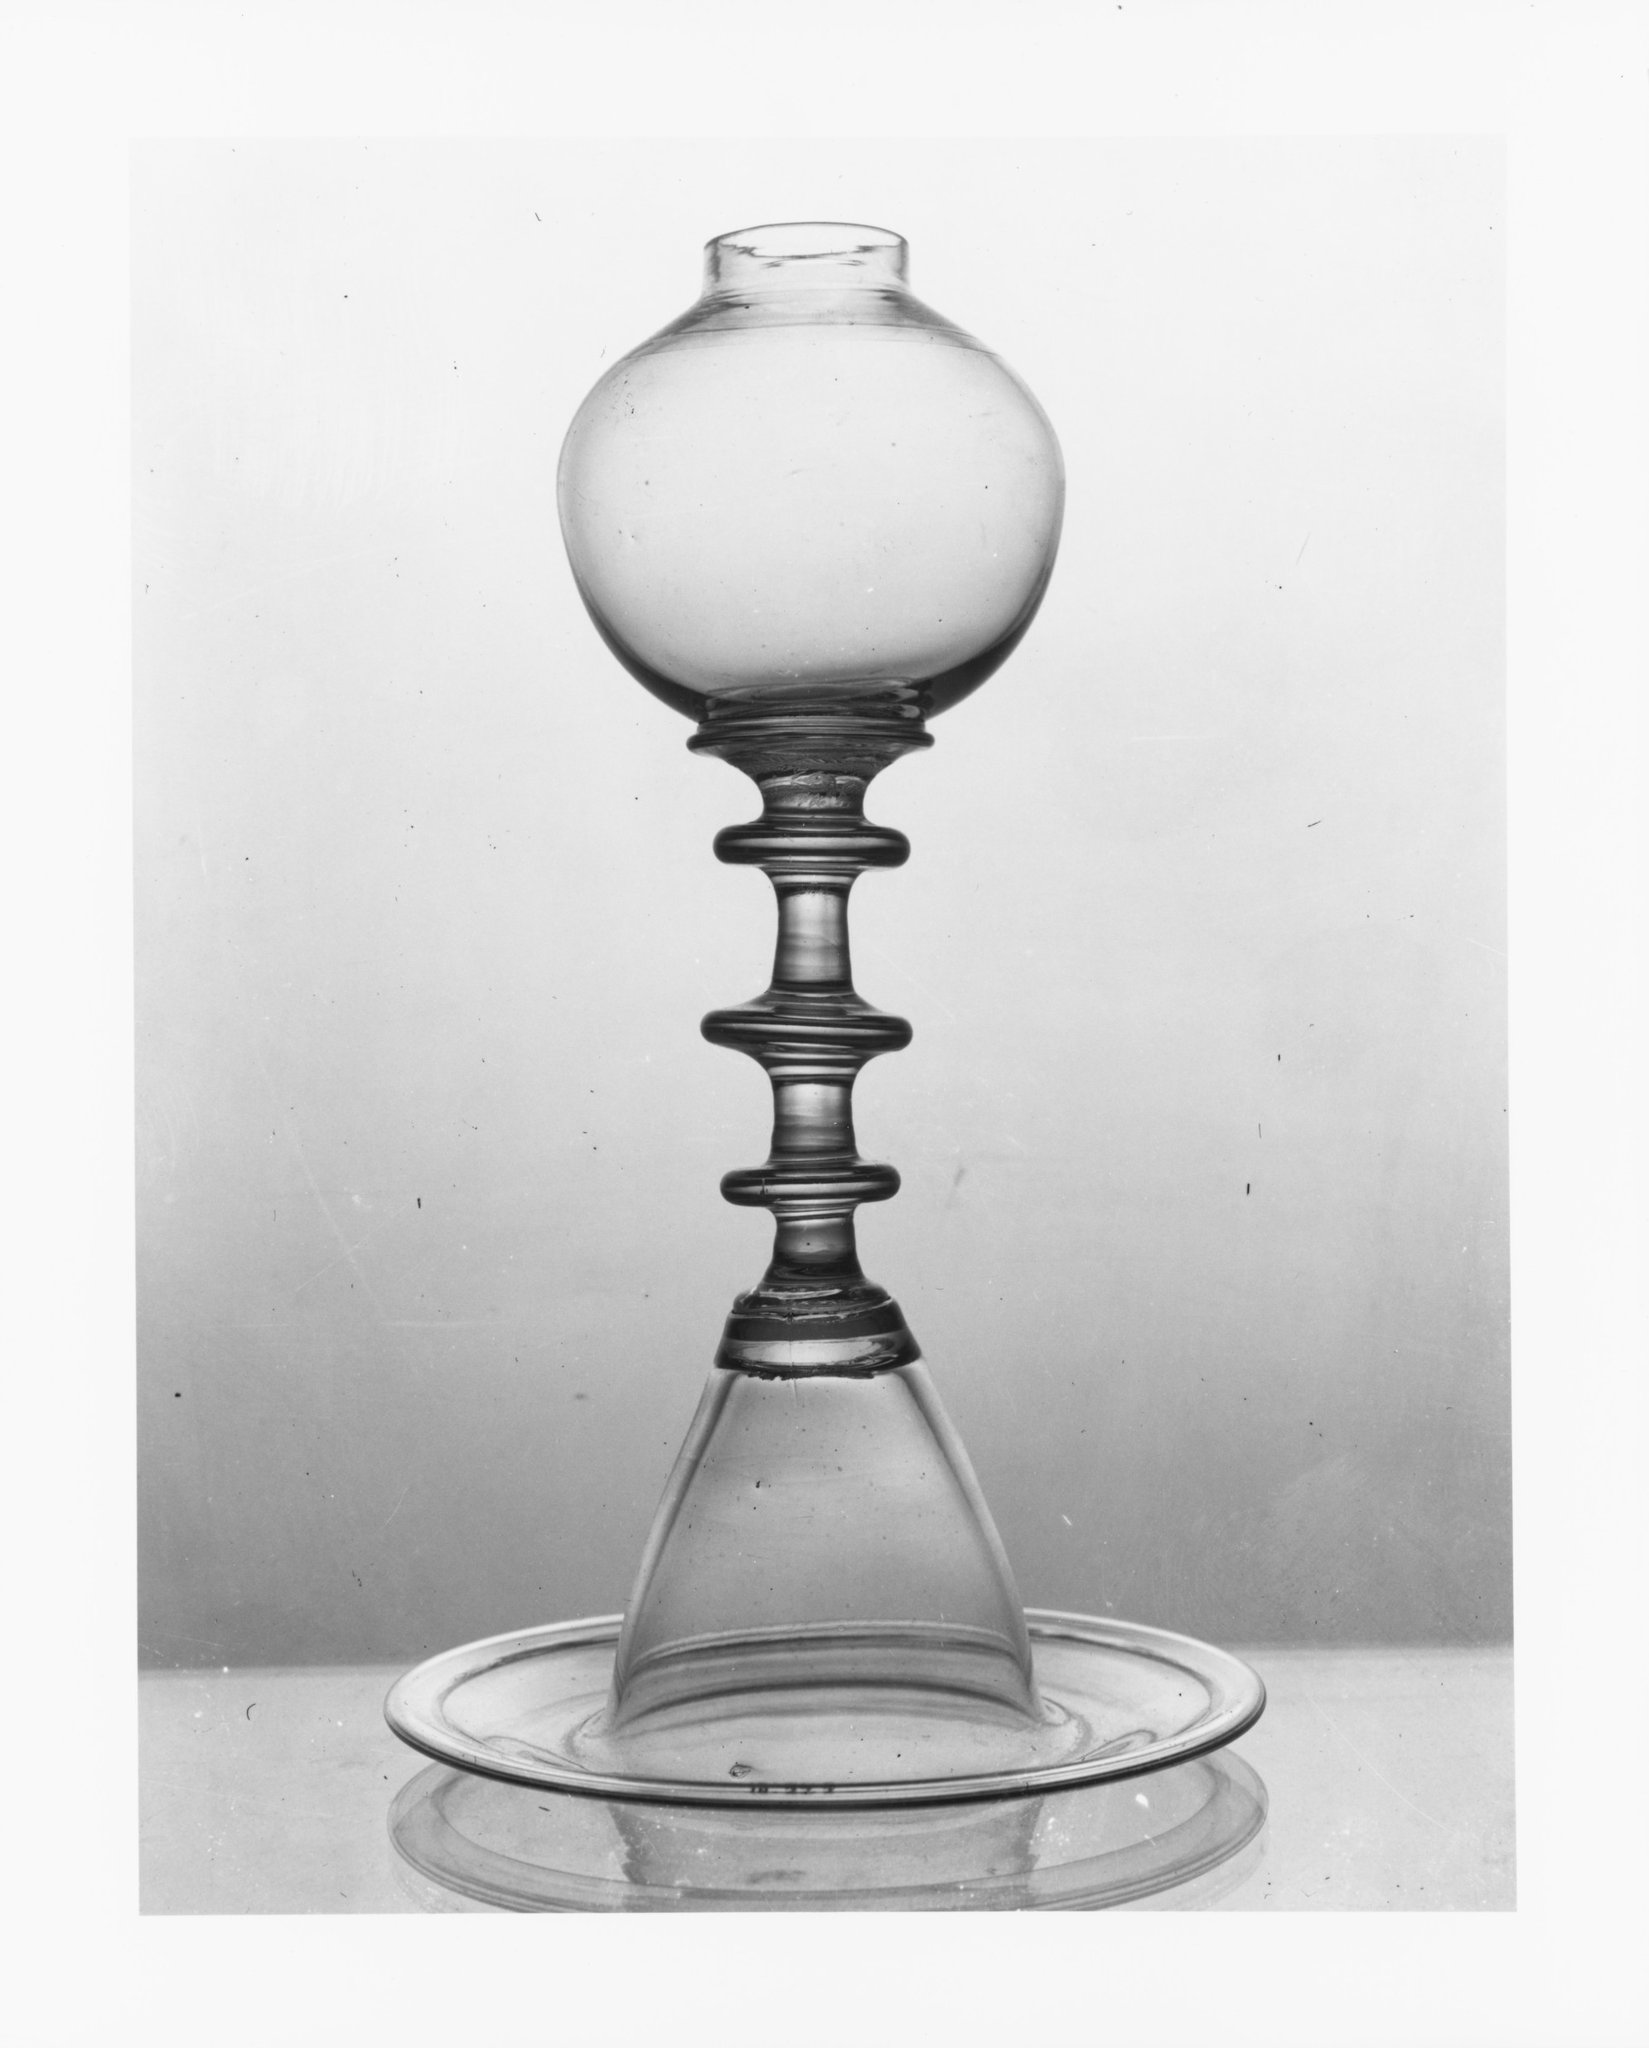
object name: lamp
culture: american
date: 1800-1830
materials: glass, lead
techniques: glassblowing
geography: united states